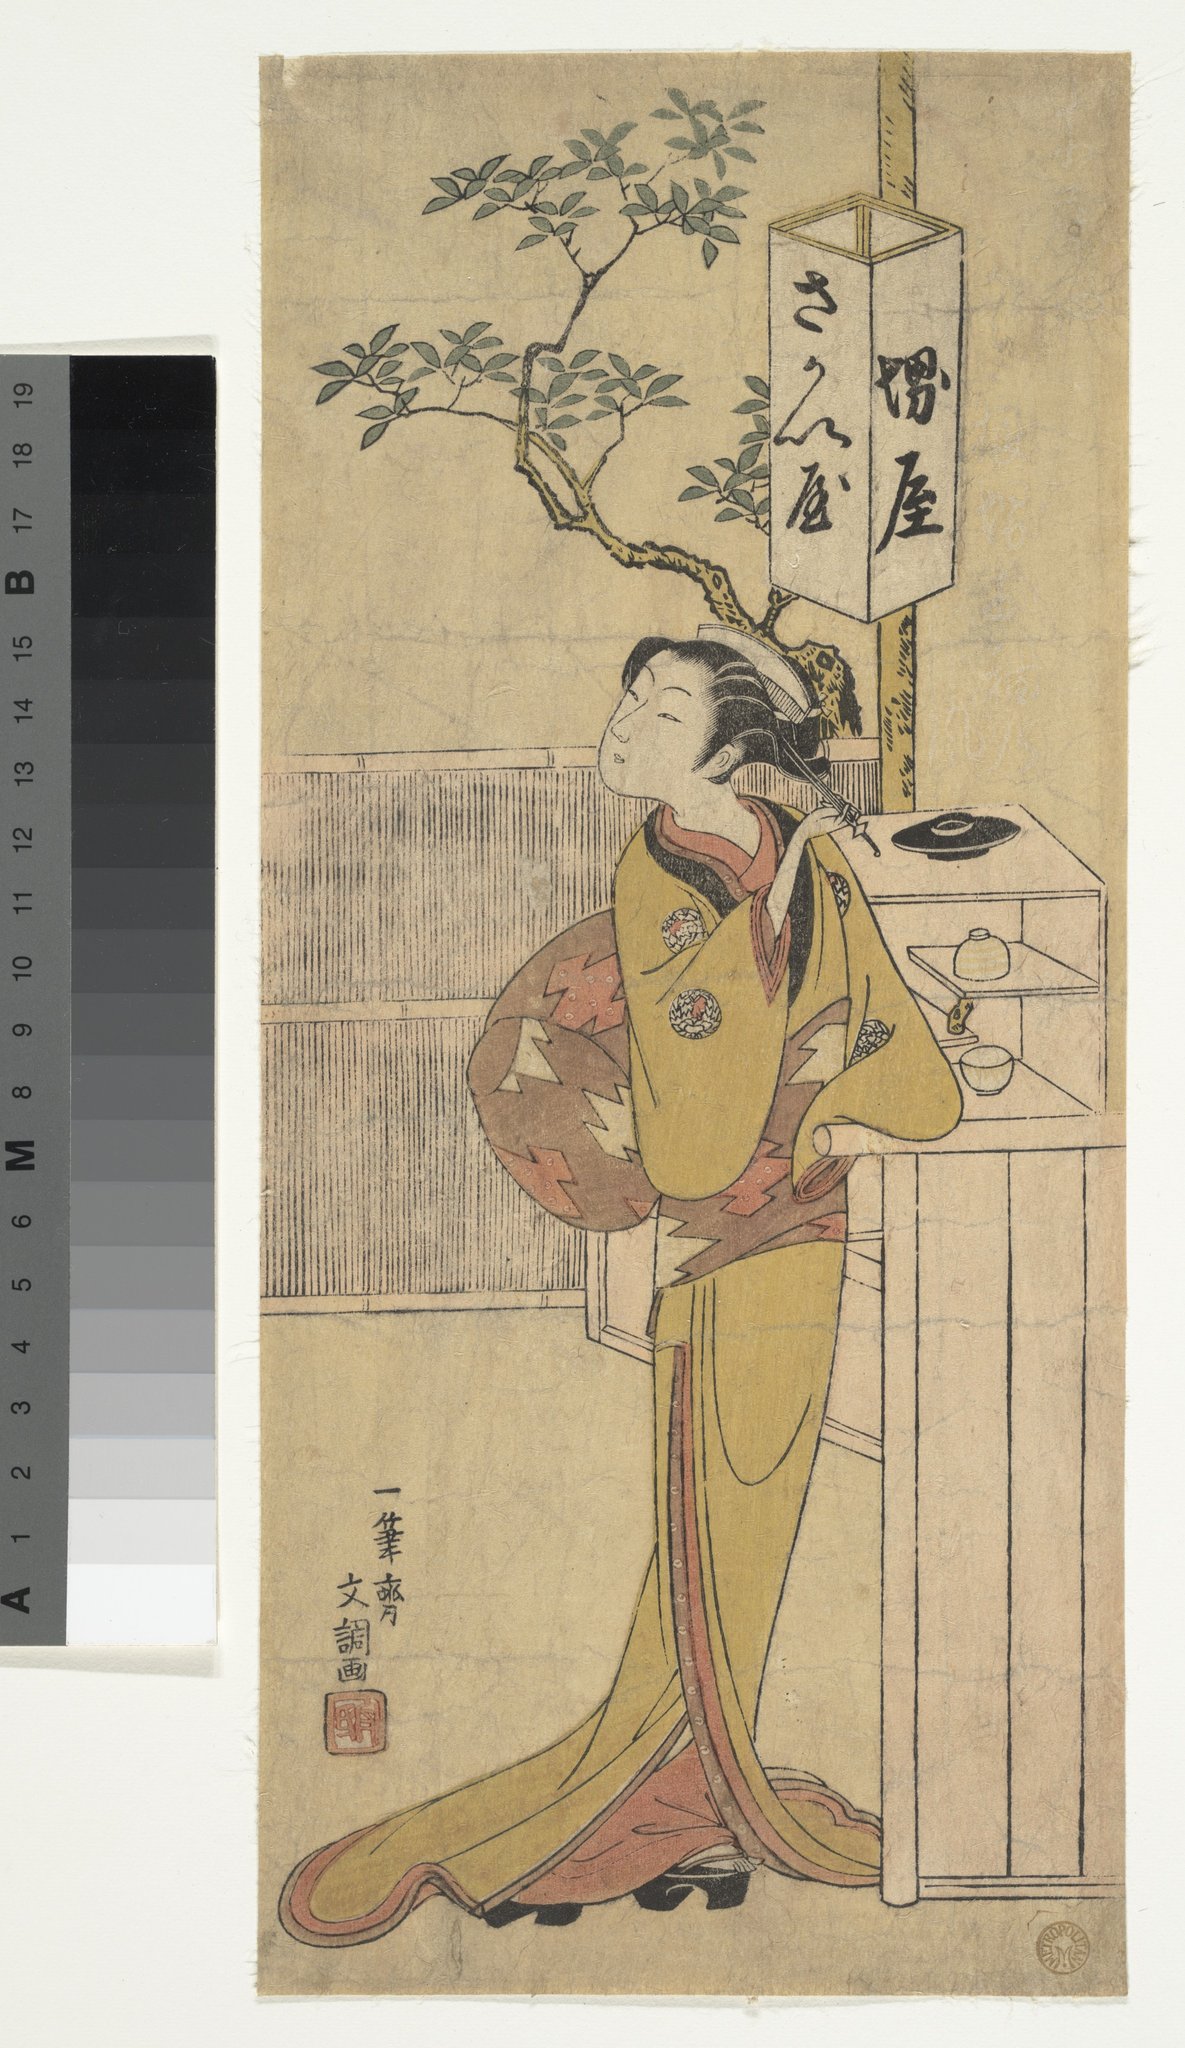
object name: print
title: A Waitress of the Sakai-ya Teahouse Standing and Looking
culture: japanese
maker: ippitsusai bunchō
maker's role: artist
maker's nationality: japanese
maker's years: 1765-1792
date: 1770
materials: ink, paper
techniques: woodblock print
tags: women,tea houses